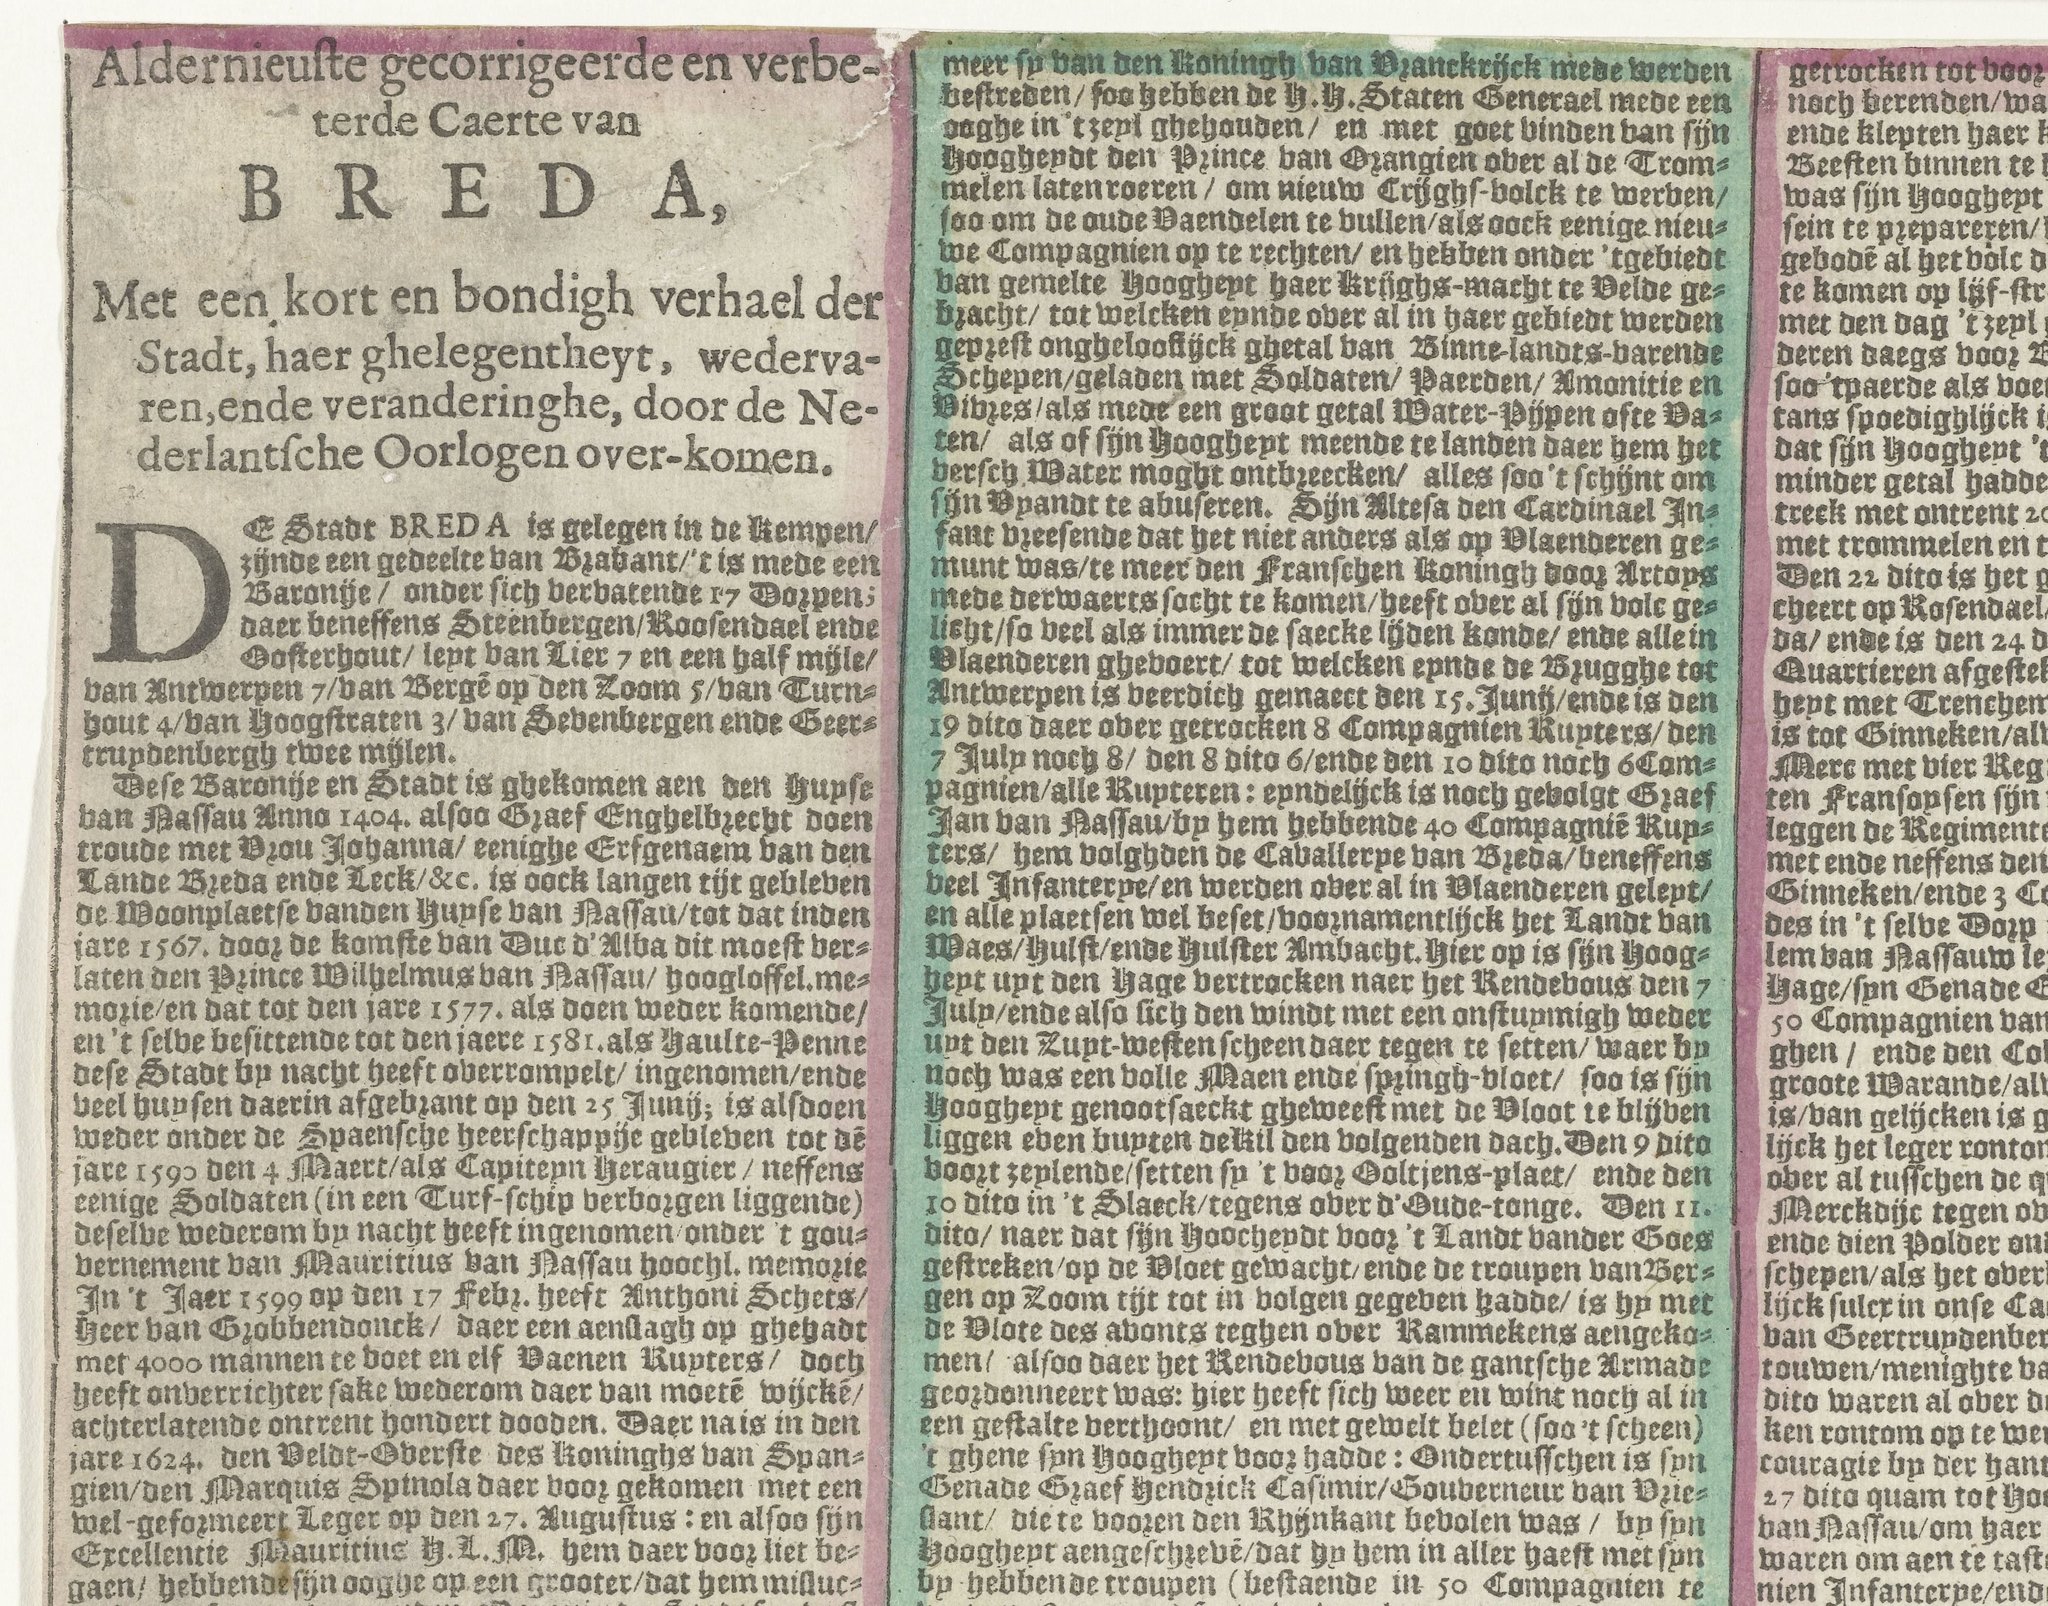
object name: text sheet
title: Tekstblad bij de kaart van het beleg van Breda (linkerhelft), 1637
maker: claes jansz. visscher (ii)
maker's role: draughtsman, print maker, publisher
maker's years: 1586-1652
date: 1637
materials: paper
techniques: hand coloring, letterpress printing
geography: amsterdam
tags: delft, frederick henry (prince of orange)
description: Tekstblad bij de kaart van de belegering van Breda door het Staatse leger onder Frederik Hendrick, 23 juli - 10 oktober 1637. Tekstblad (linkerhelft) met een beschrijving van de gebeurtenissen in 3 lange kolommen.